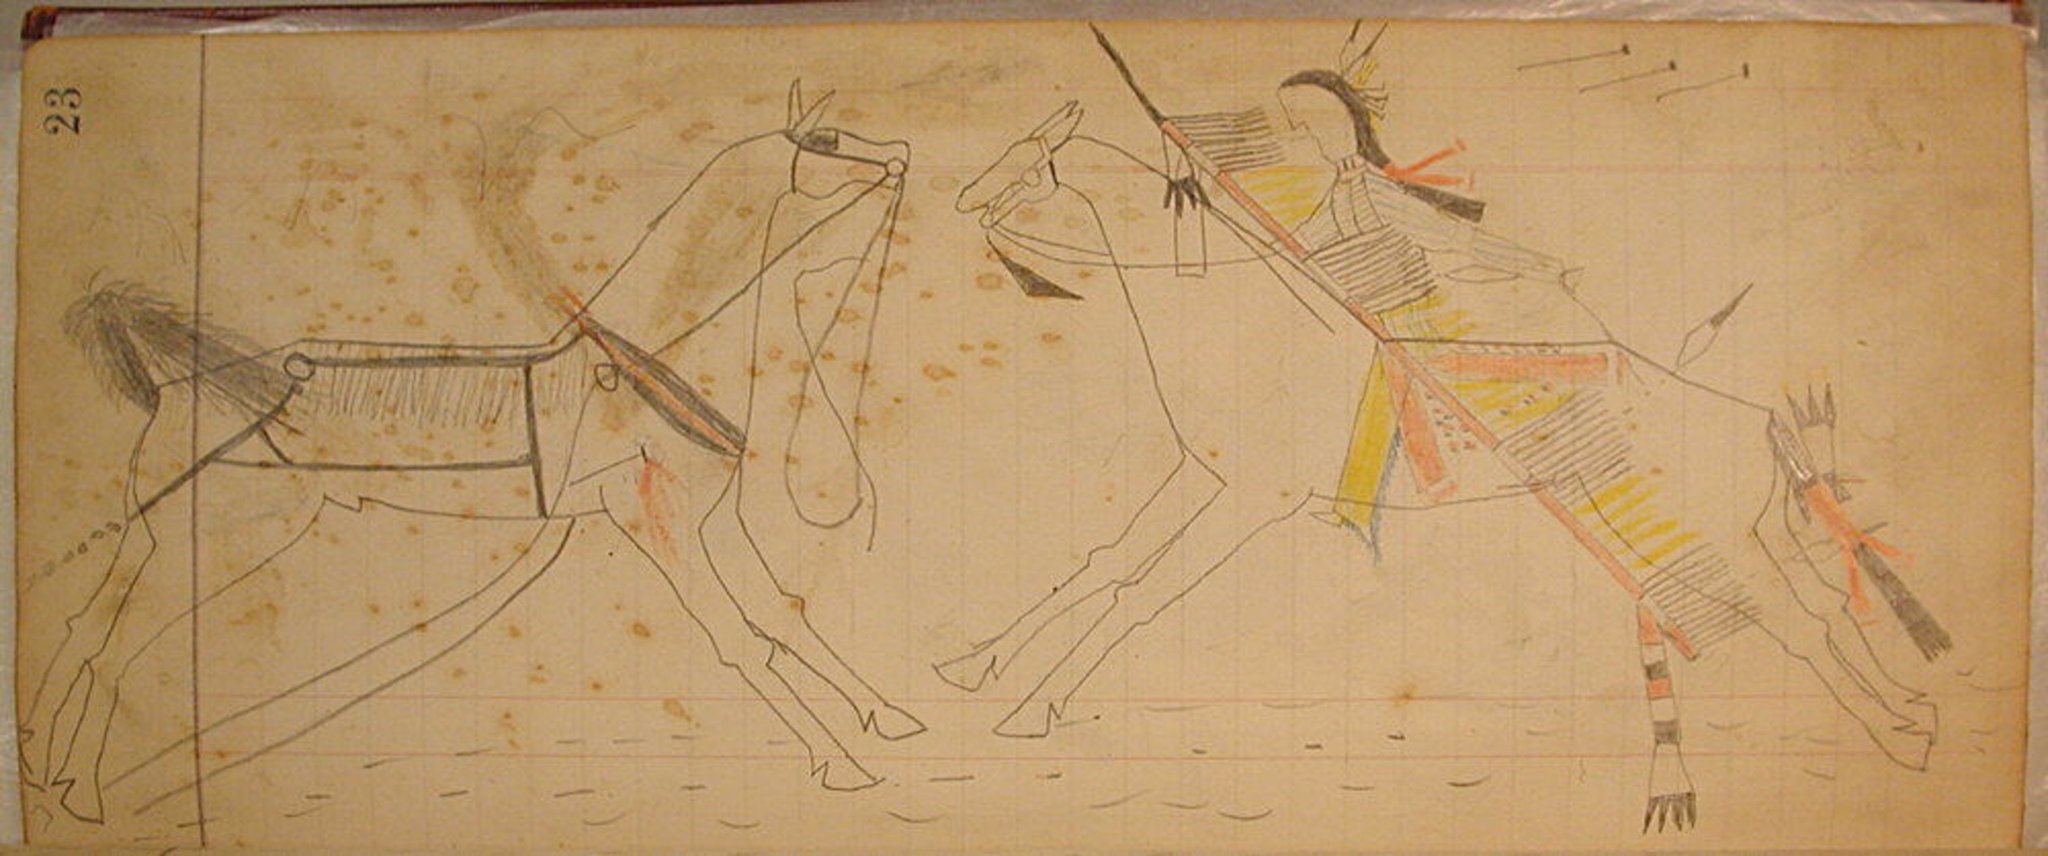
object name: drawing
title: Maffet Ledger: Indian and two horses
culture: cheyenne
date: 1874-1881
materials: crayon, graphite, paper, watercolor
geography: united states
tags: spears,men,horses